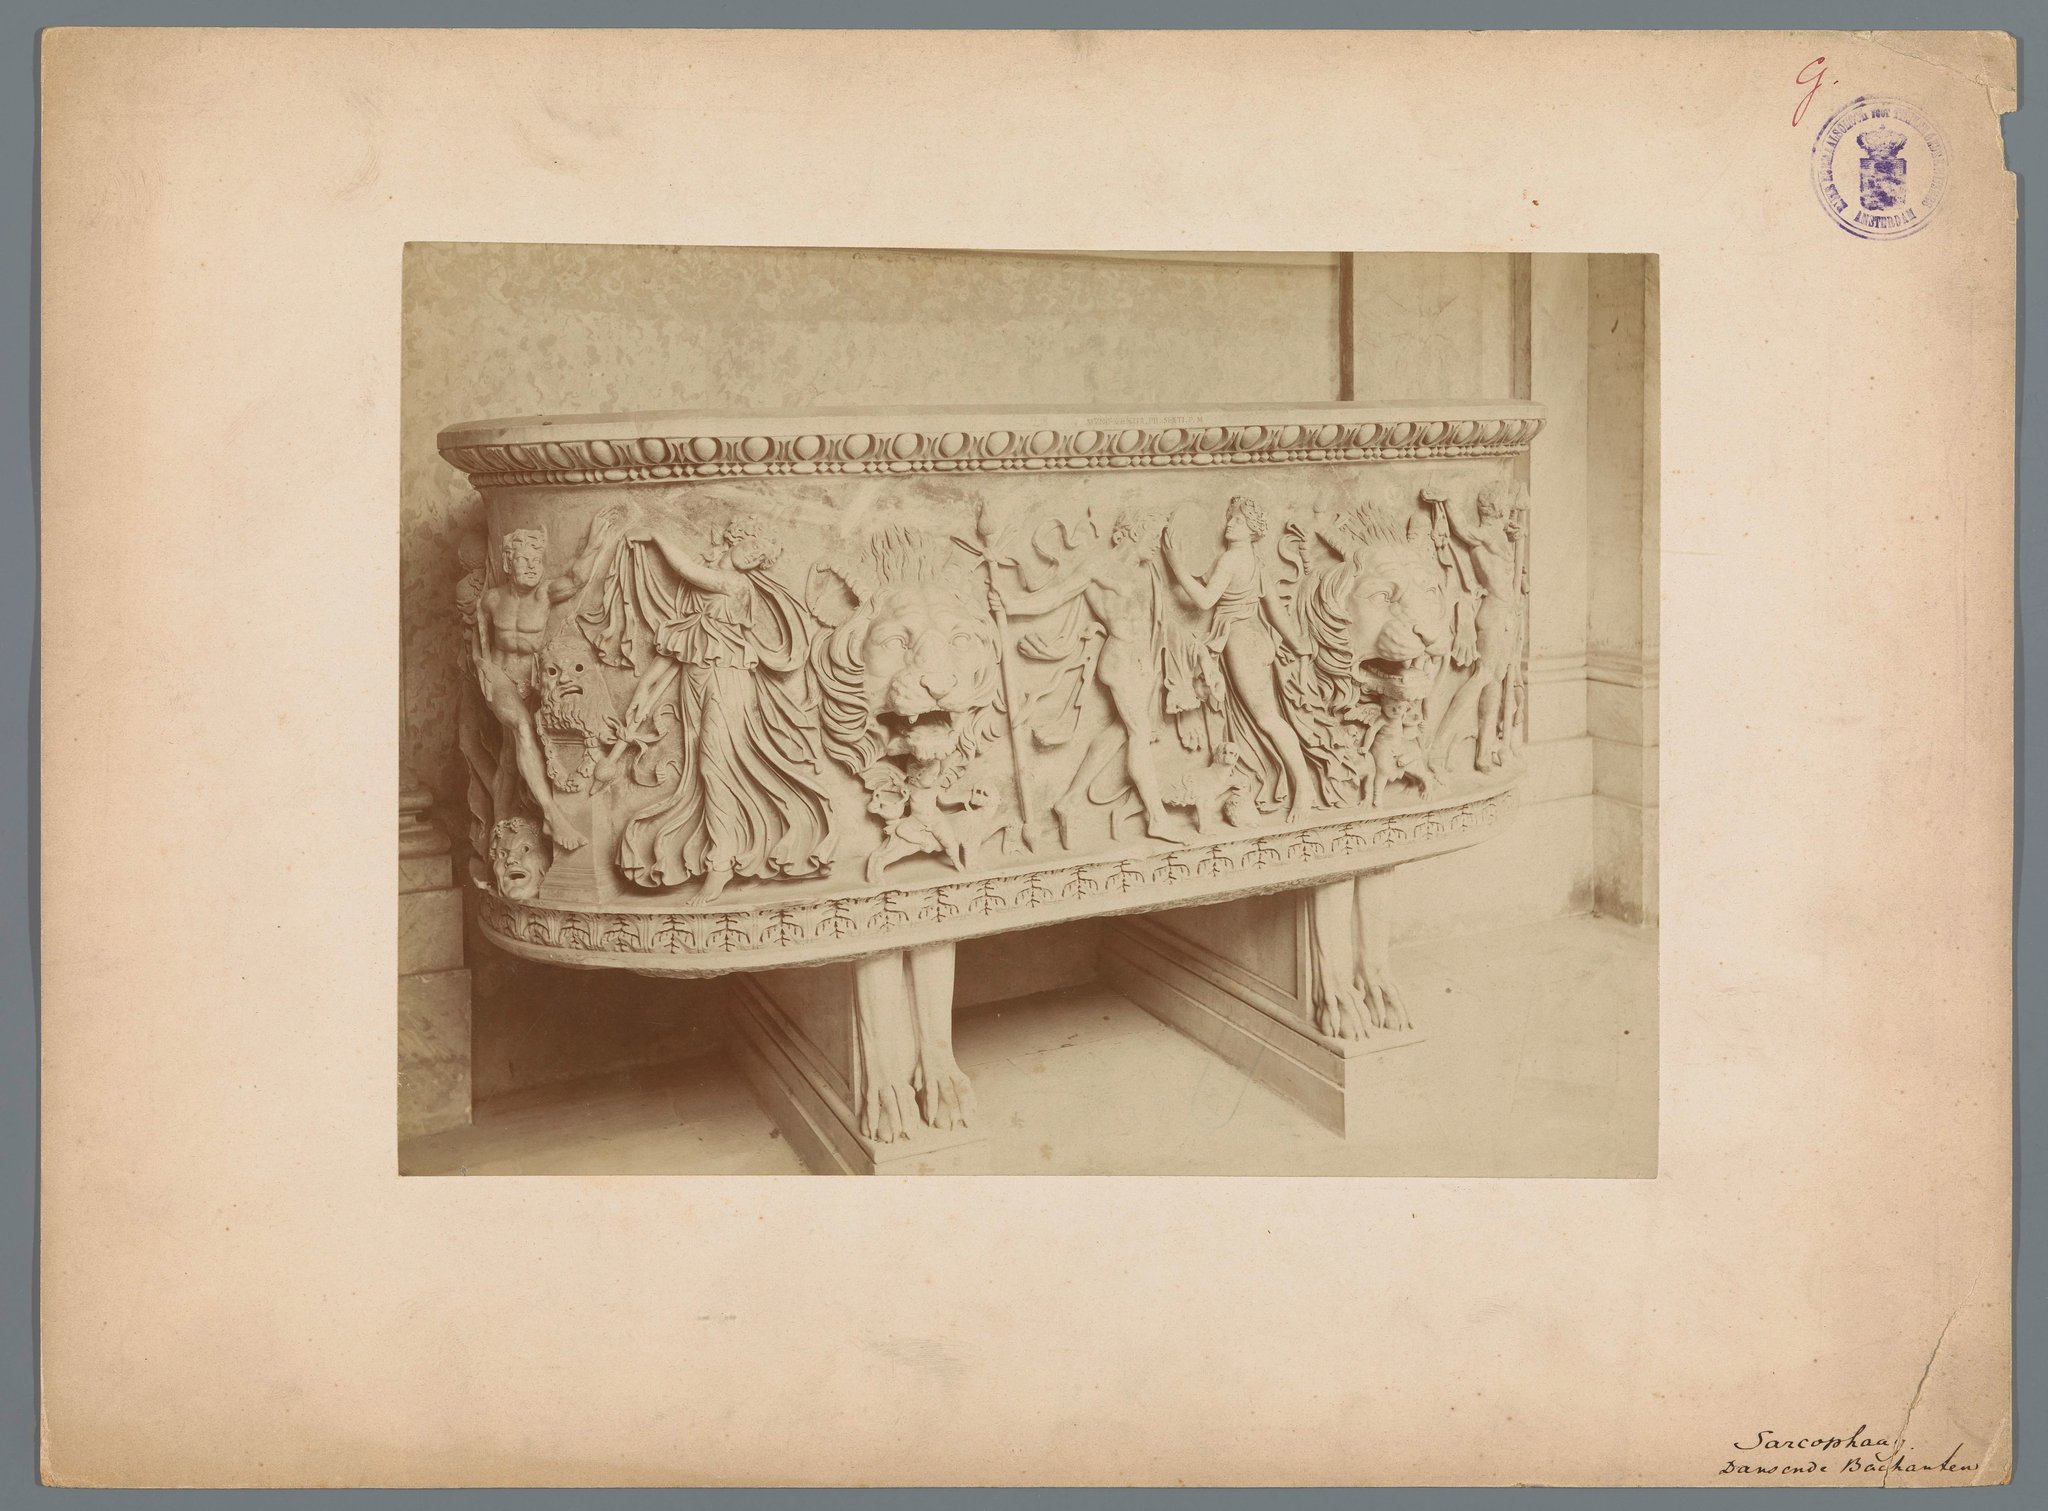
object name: photograph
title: Sarcofaag met dansende bacchanten en leeuwenkoppen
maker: Anonymous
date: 1875-1900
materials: cardboard, photographic support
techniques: albumen print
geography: europe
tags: lion's head ~ ornament, male bacchant(es), sarcophagus, sculpture (+ relief ~ sculpture), europe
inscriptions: inscription: ‘Sarcophaag. Dansende Bacchanten’, collector's mark: ‘RIJKS-NORMAALSCHOOL voor TEEKENONDERWIJZERS AMSTERDAM’